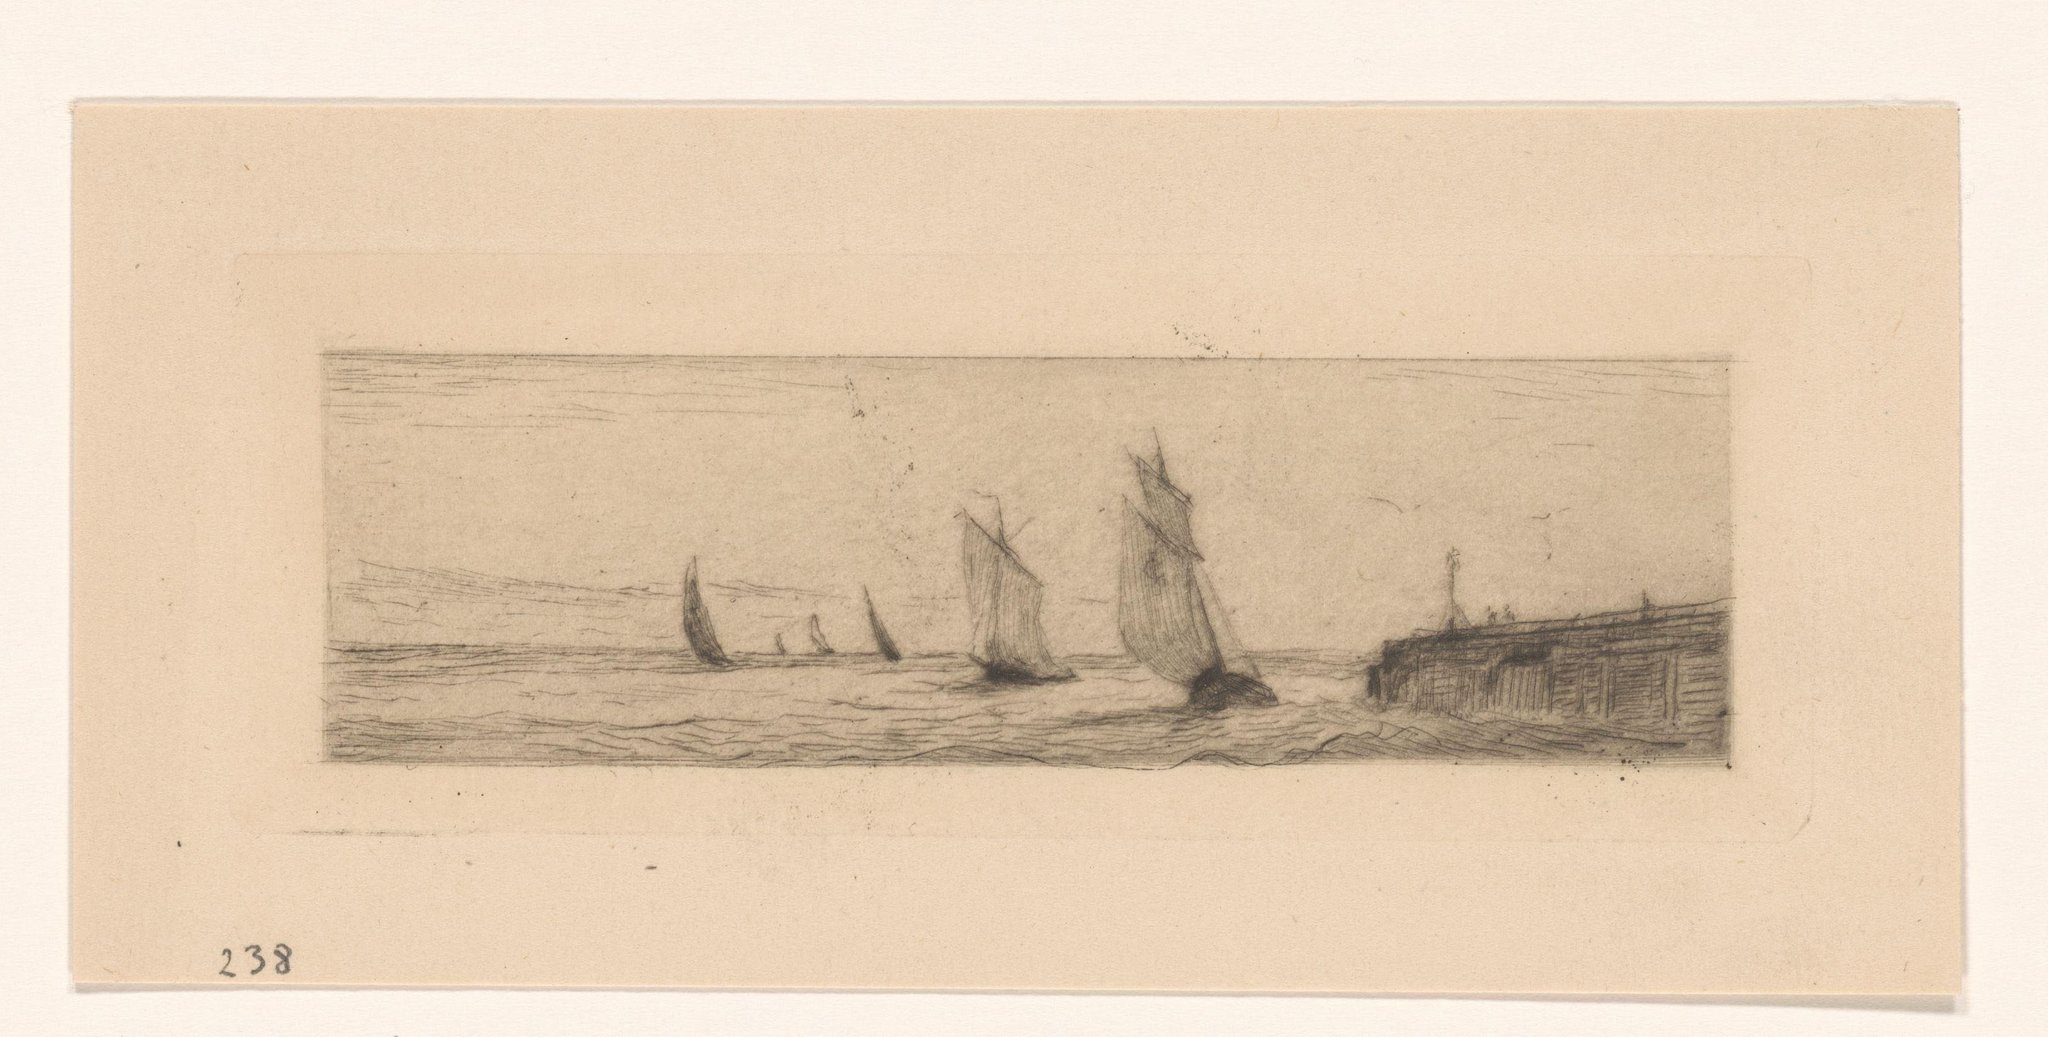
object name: print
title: Binnenkomende vissersboten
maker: carel nicolaas storm van s-gravesande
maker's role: draughtsman, print maker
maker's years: 1841-1924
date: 1887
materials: paper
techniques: drypoint, intaglio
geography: netherlands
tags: commercial fishery, sailing-ship, sailing-boat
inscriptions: collector's mark: Lugt 2228